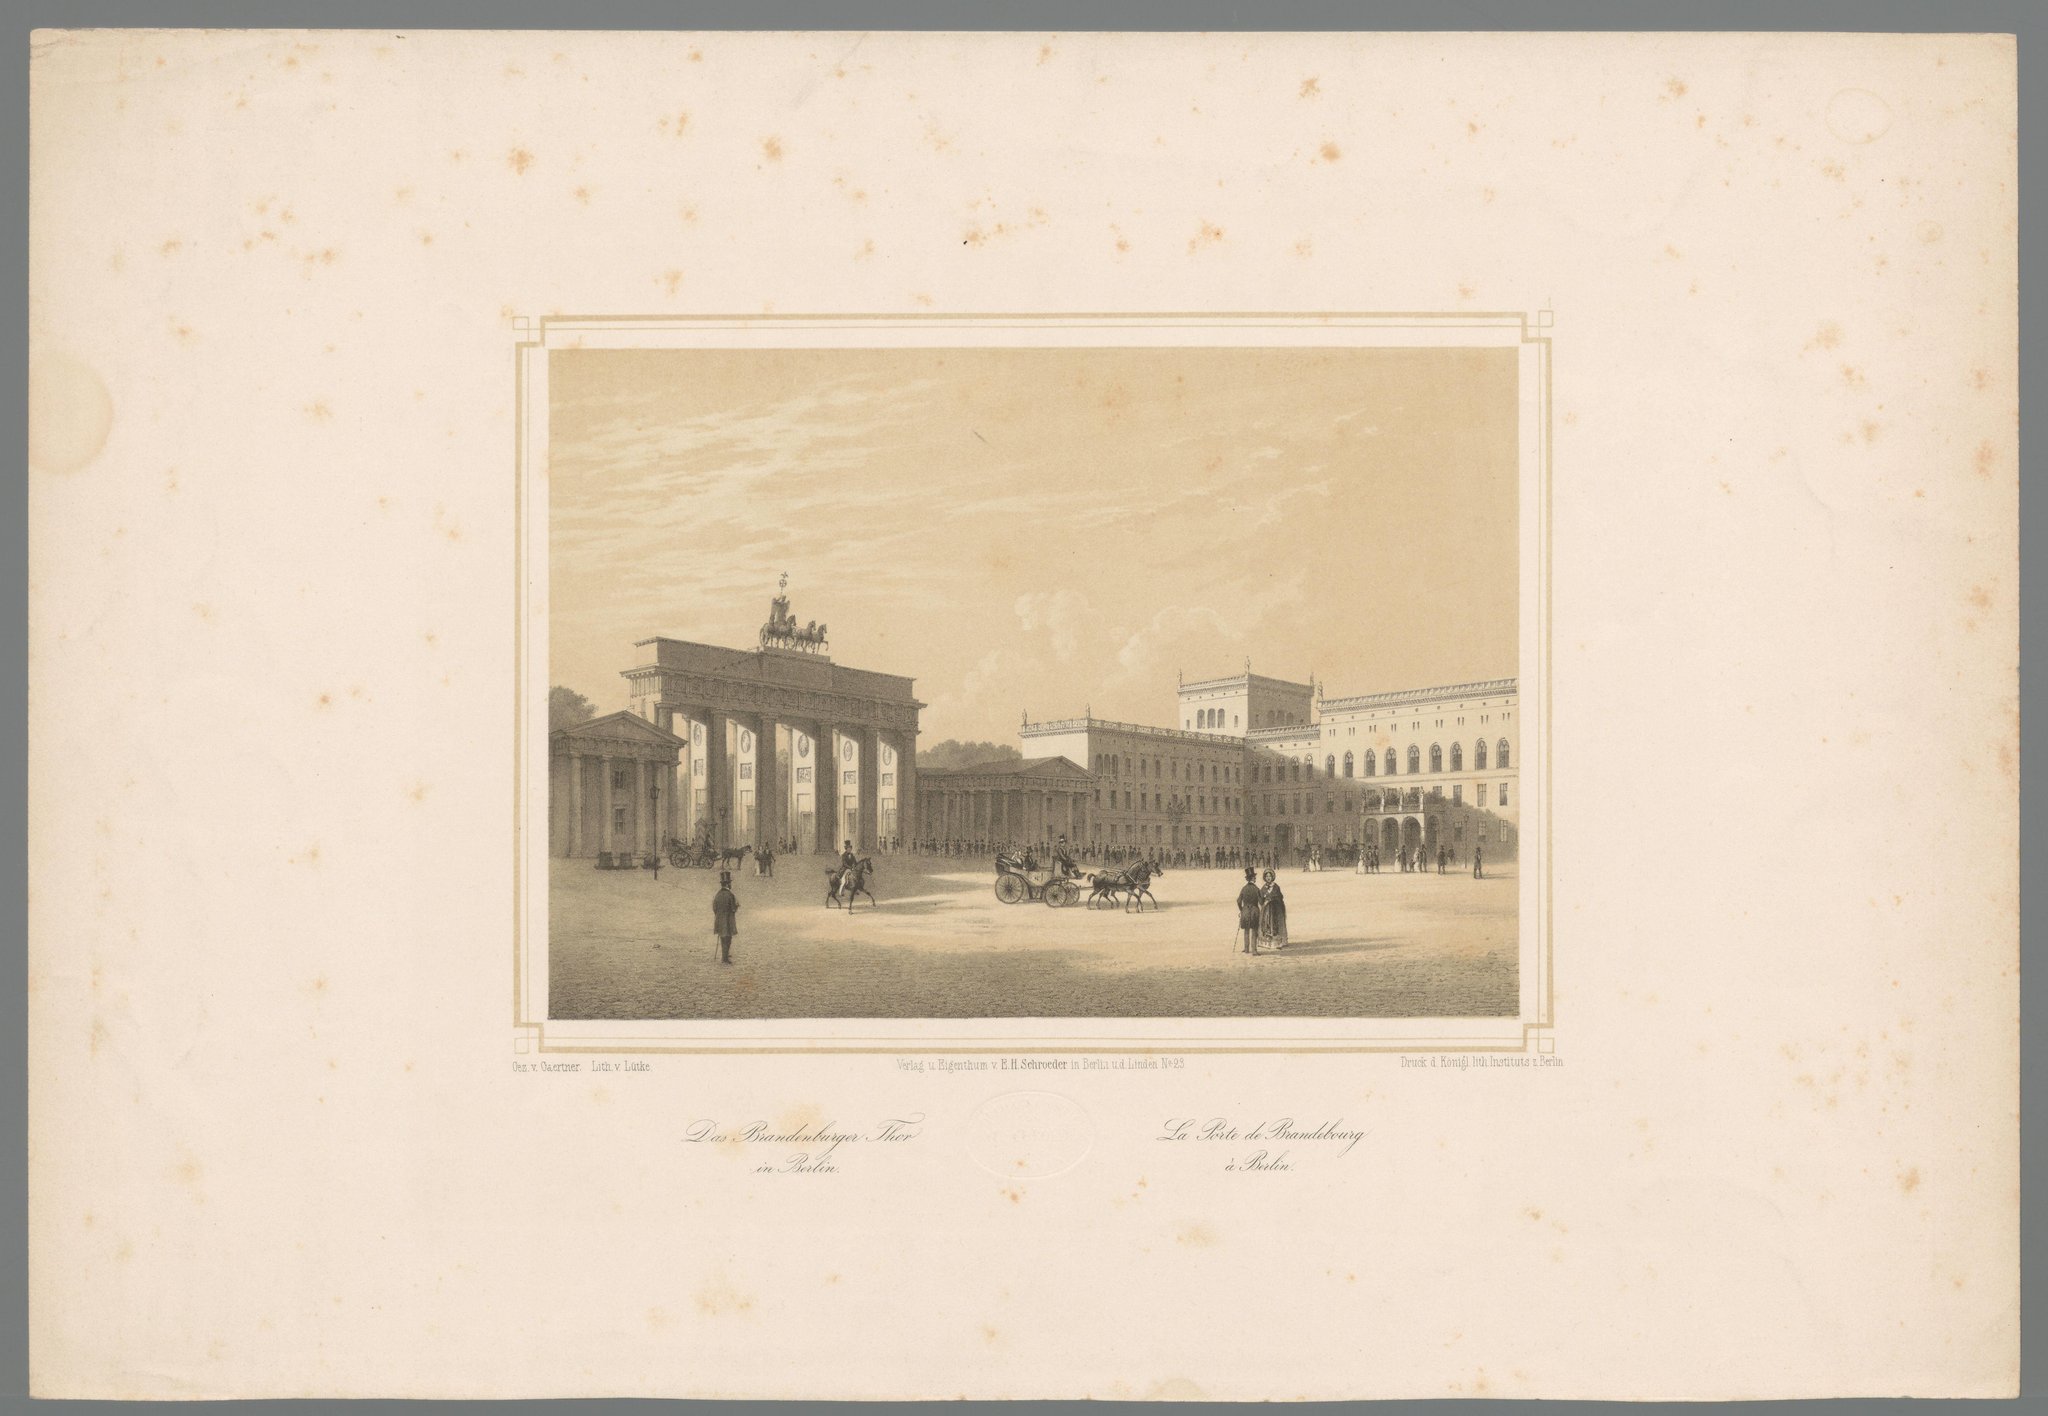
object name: print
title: Das Brandenburger Thor in Berlin / La Porte de Brandebourg à Berlin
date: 1840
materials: paper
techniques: tone lithography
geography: berlin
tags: monument, statue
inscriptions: collector's mark: Lugt 2233, check stamp: ‘Buch u. Kunsth. von E.H. Schroeder in Berlin’